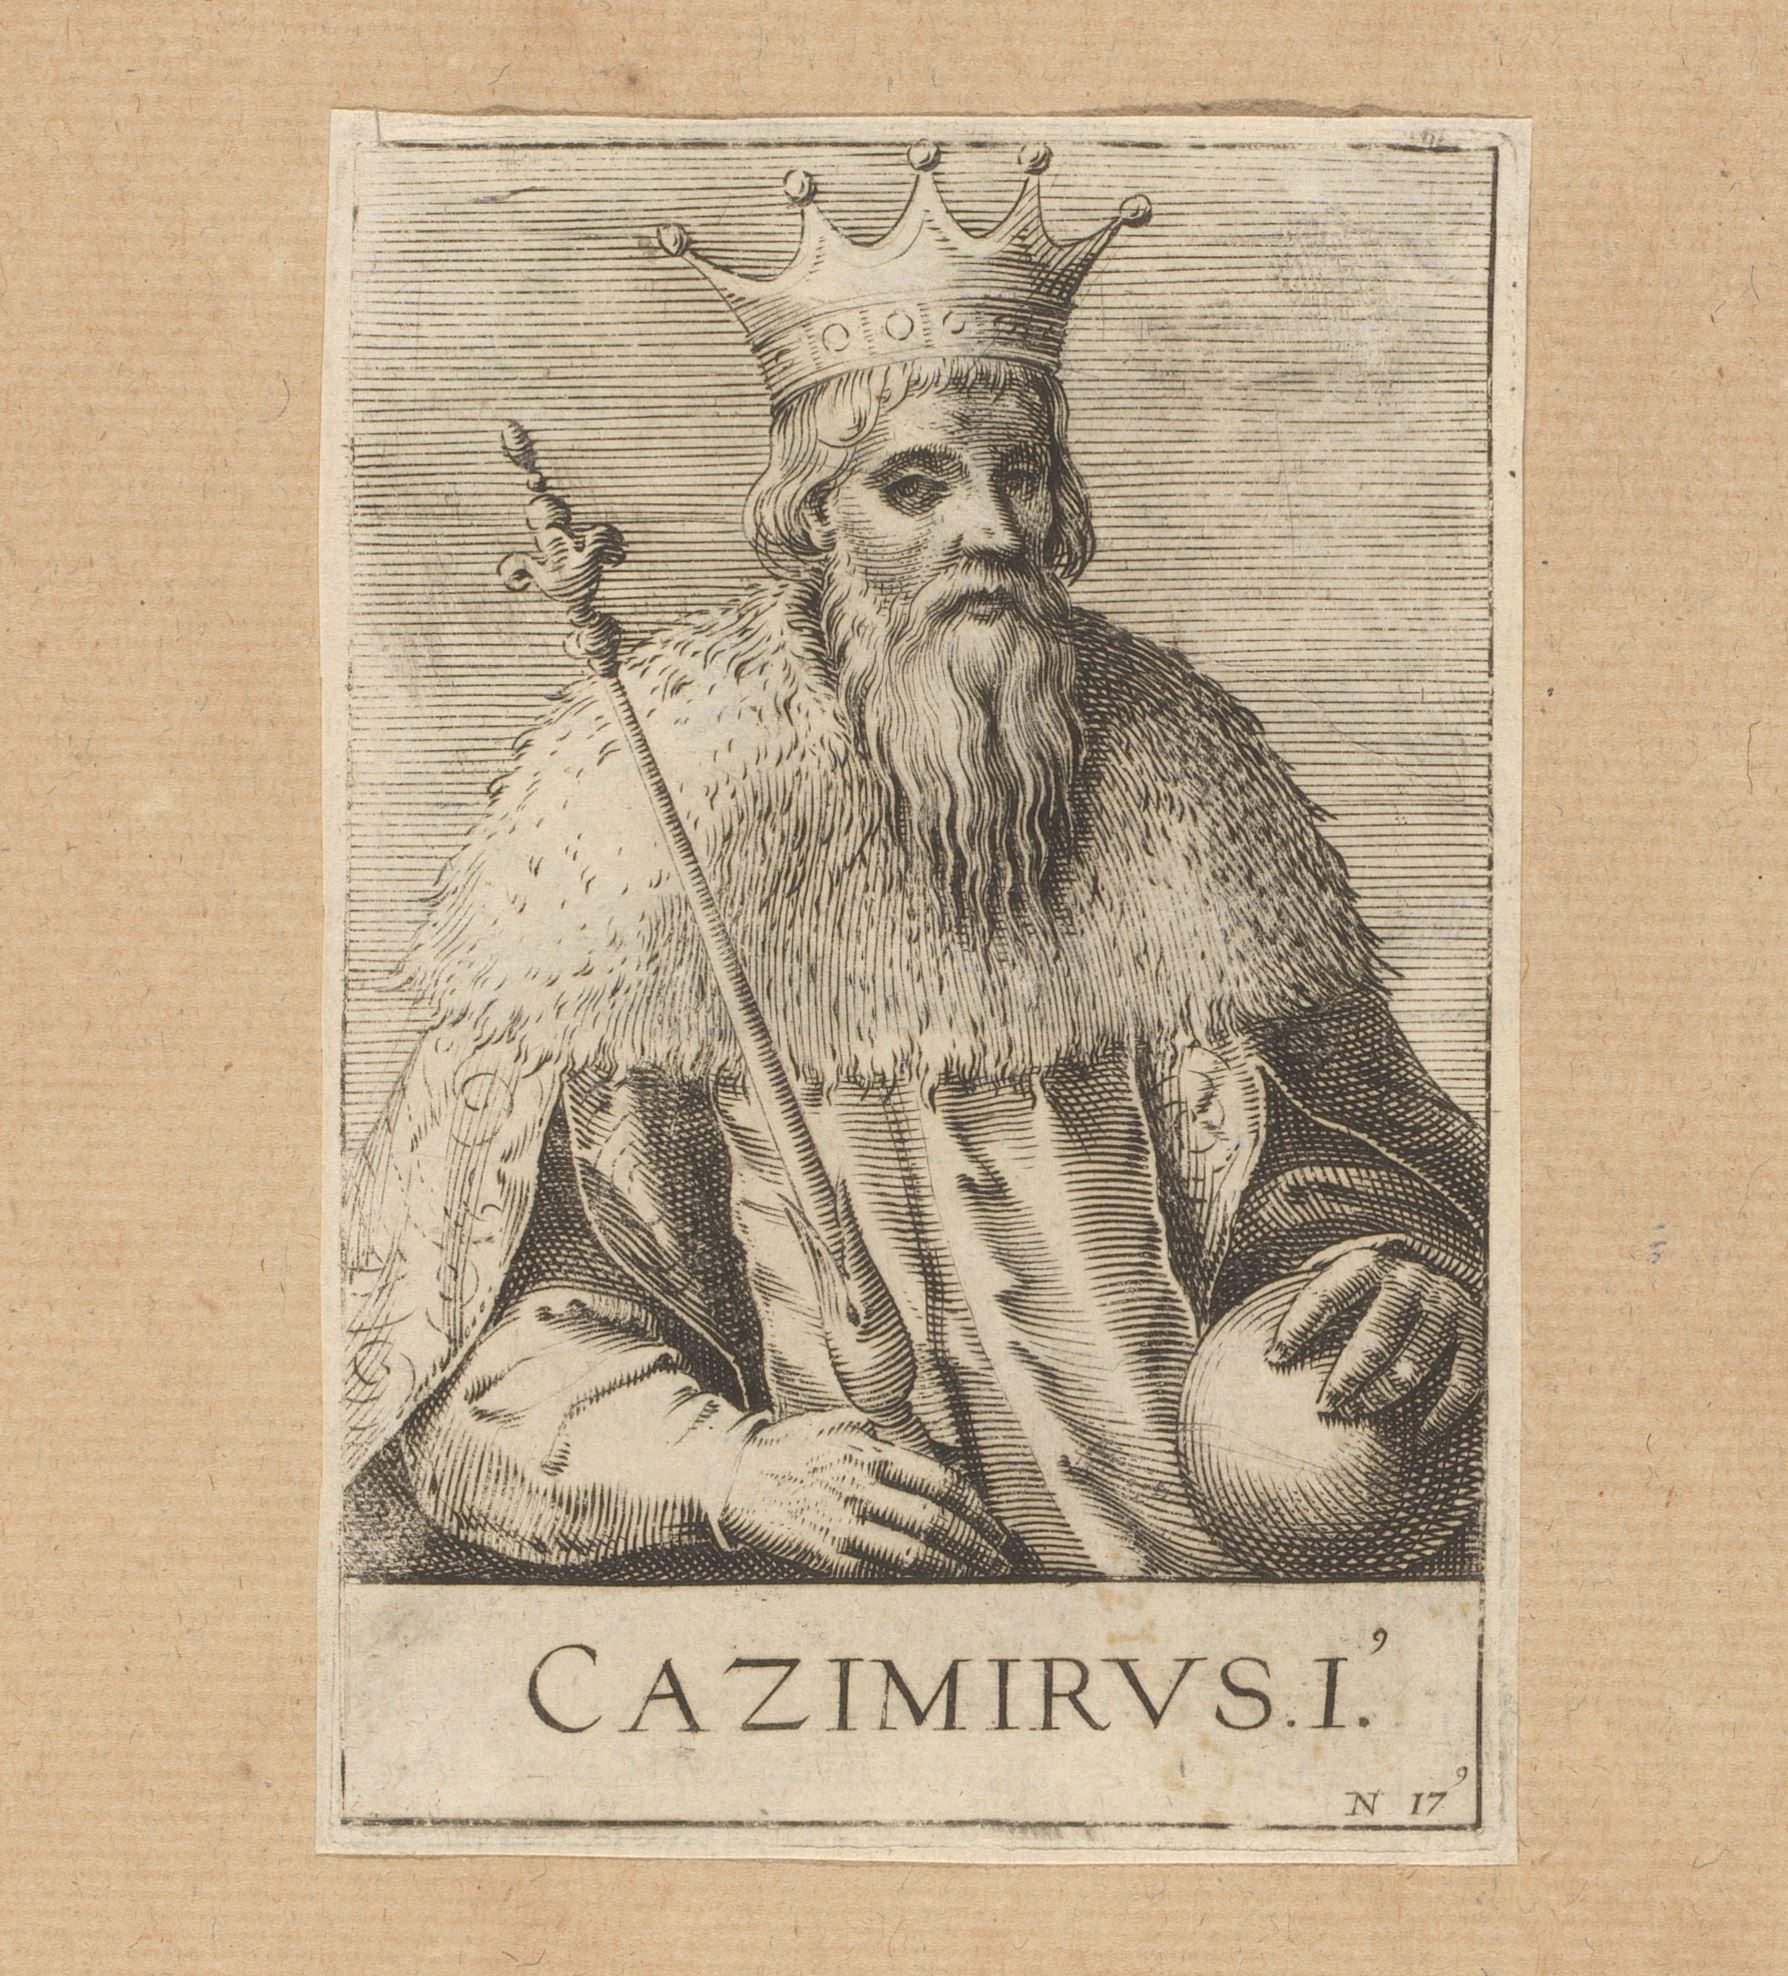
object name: album leaf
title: Portret van Casimir I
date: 1574-1594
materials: paper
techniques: woodcut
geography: cologne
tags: historical persons, king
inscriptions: collector's mark: Lugt 240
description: Prent gebruikt in: Mylius, Arnold. Principum et Regum Polonorum Imagines ad Vivum Expressae (...). Keulen: Gottfried von Kempen, 1594.